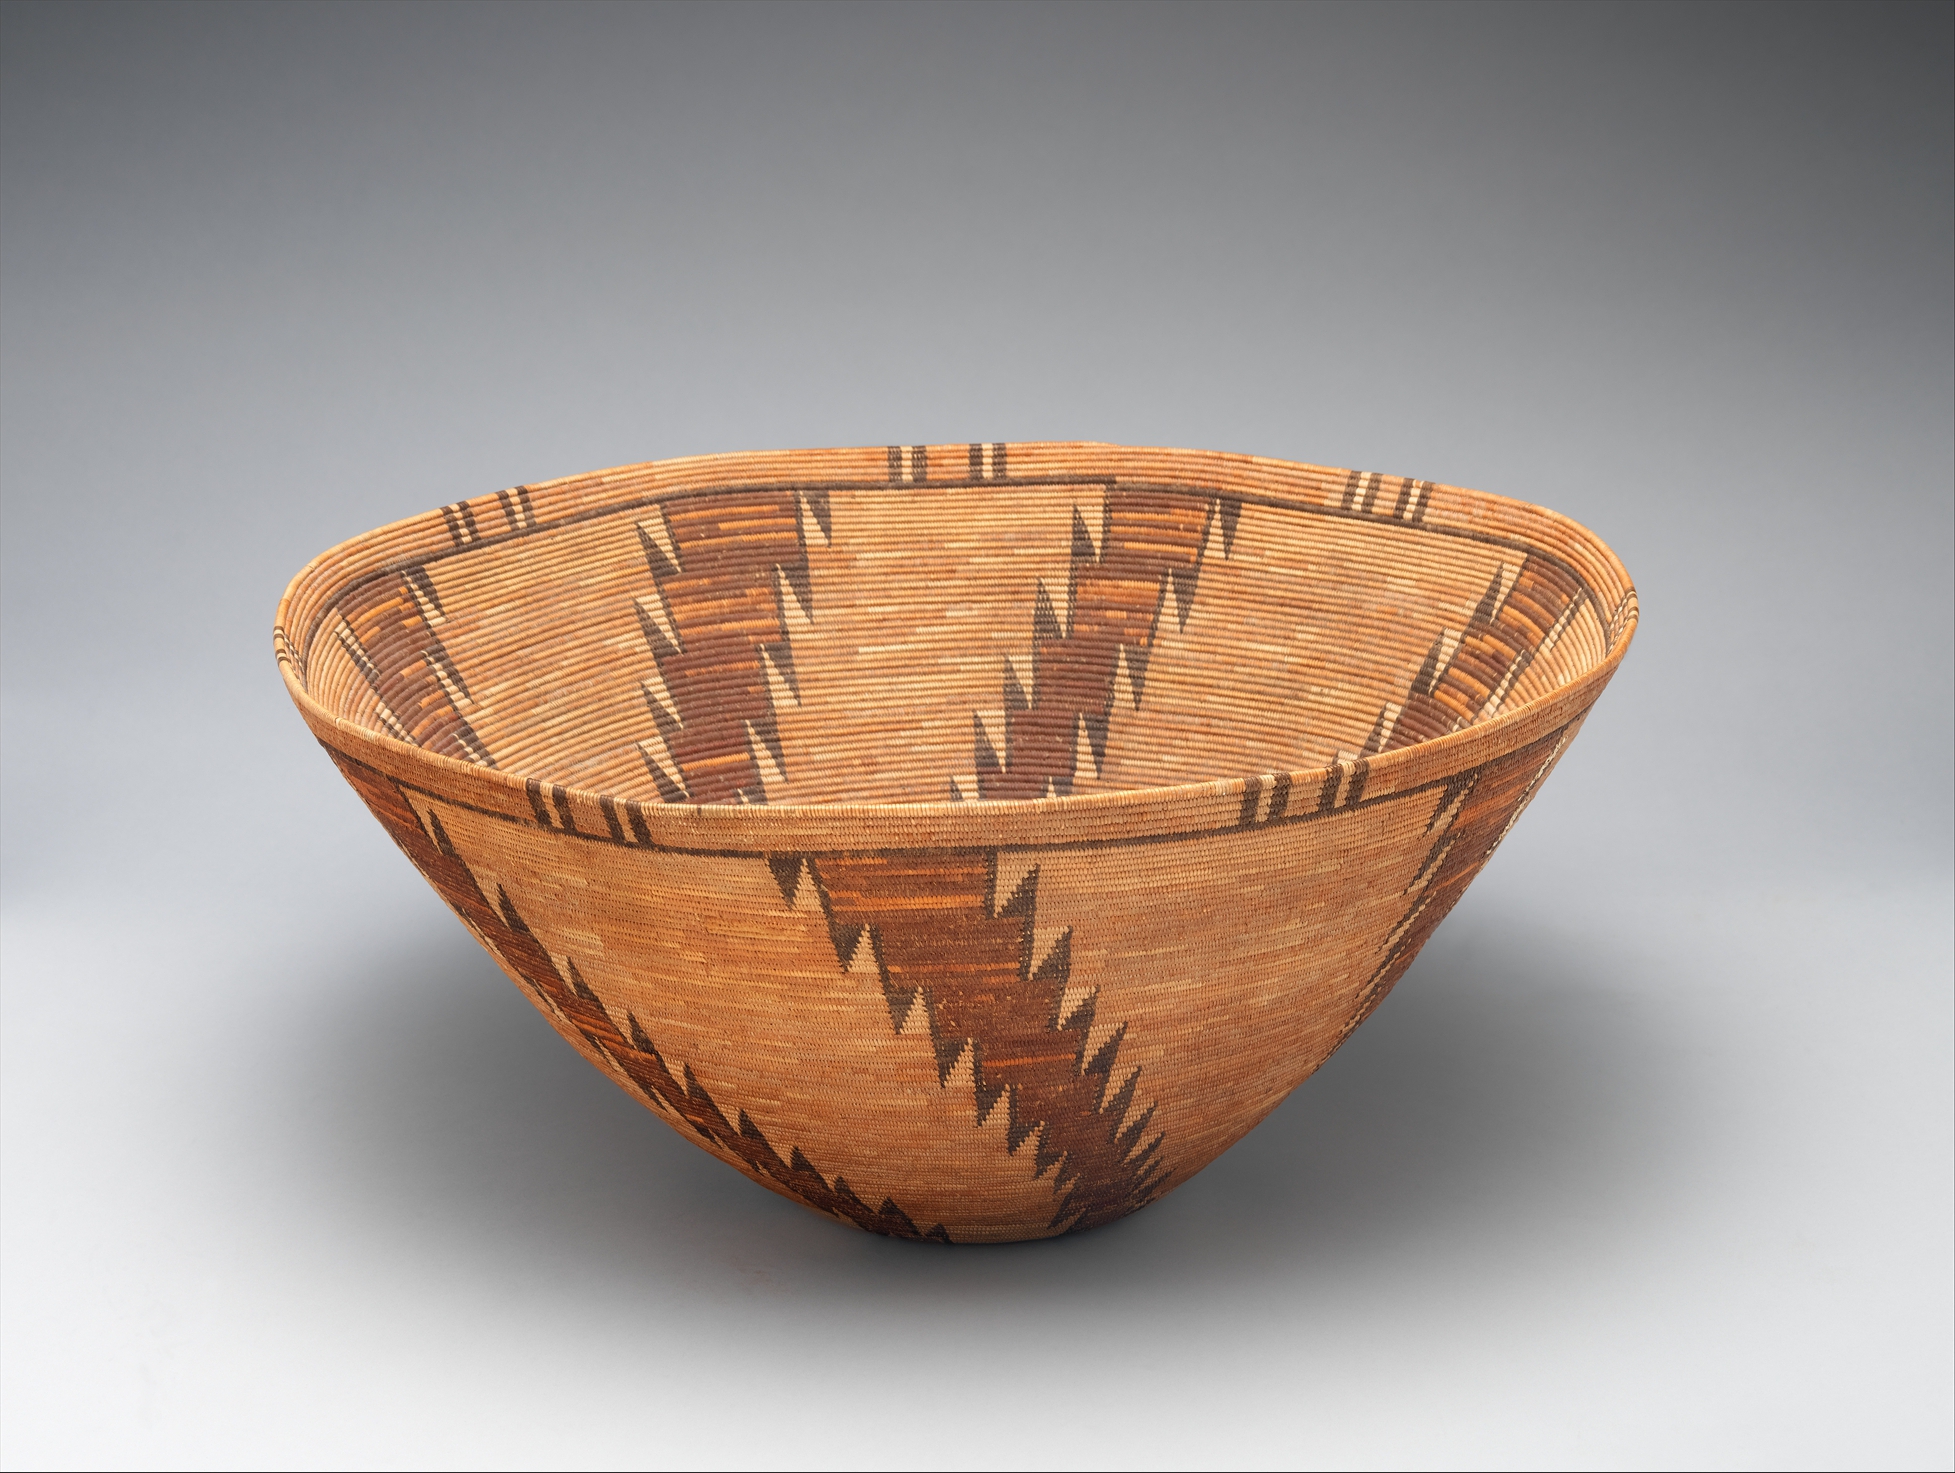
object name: basket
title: Cooking Basket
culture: tübatulabal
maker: mary tecuyas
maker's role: artist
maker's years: 1760-1916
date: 1880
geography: united states